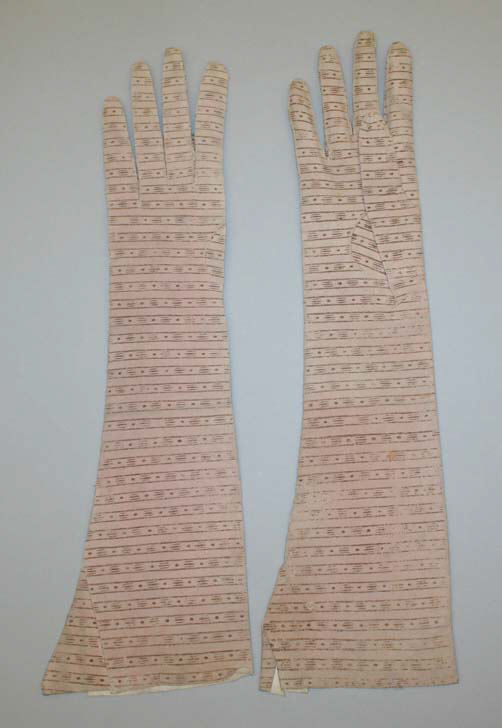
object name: glove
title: Gloves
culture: italian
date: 1767-1833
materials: leather